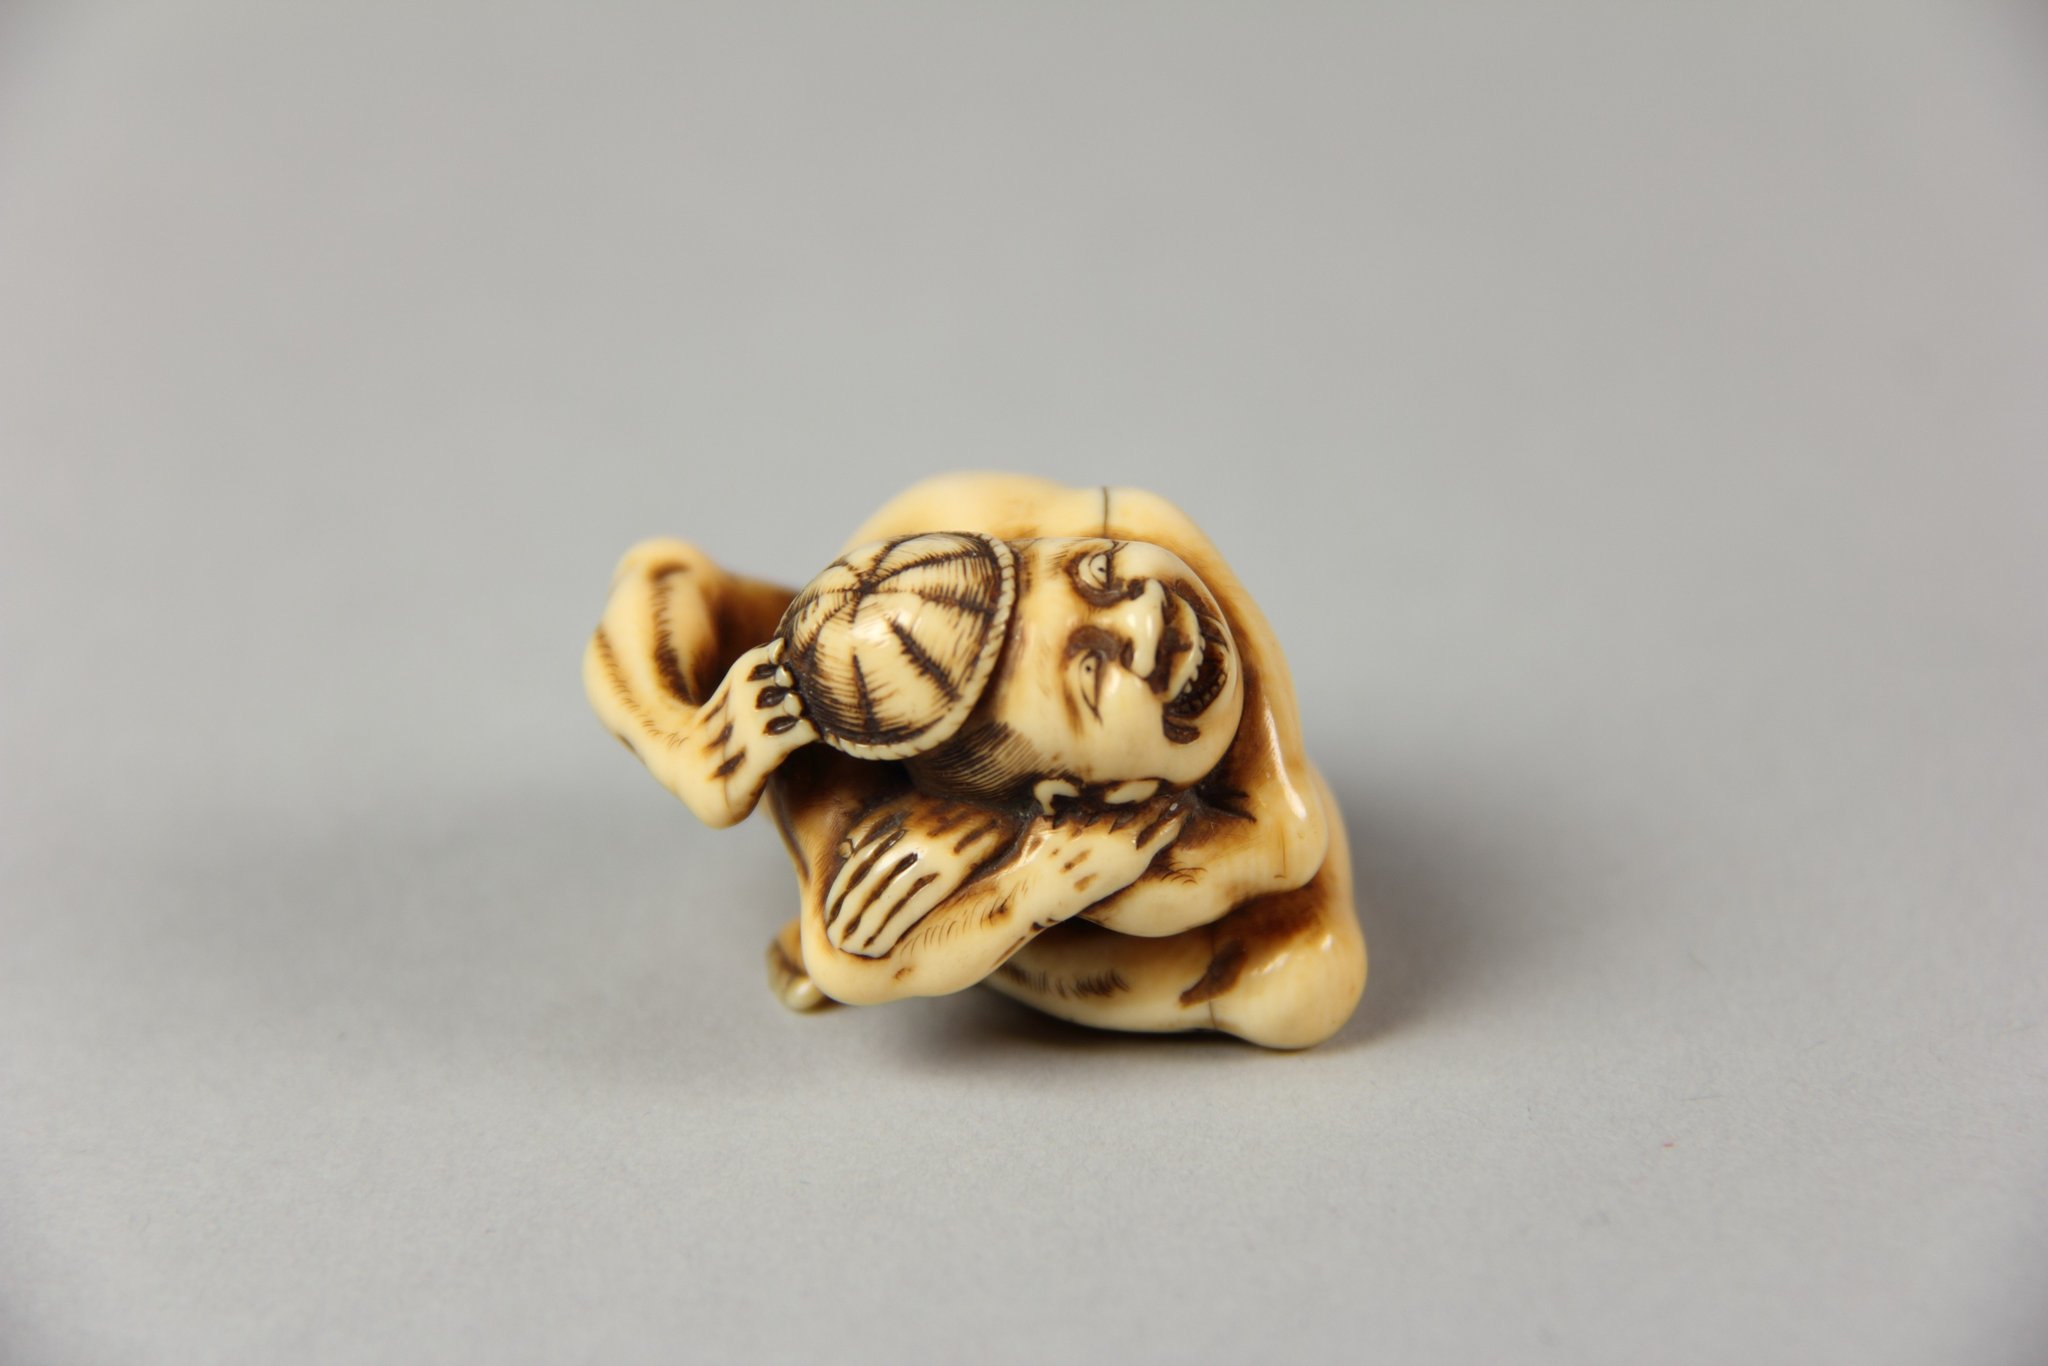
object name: netsuke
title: Netsuke of Acrobat Removing his Hat with His Foot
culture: japanese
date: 1801-1900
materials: ivory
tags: men